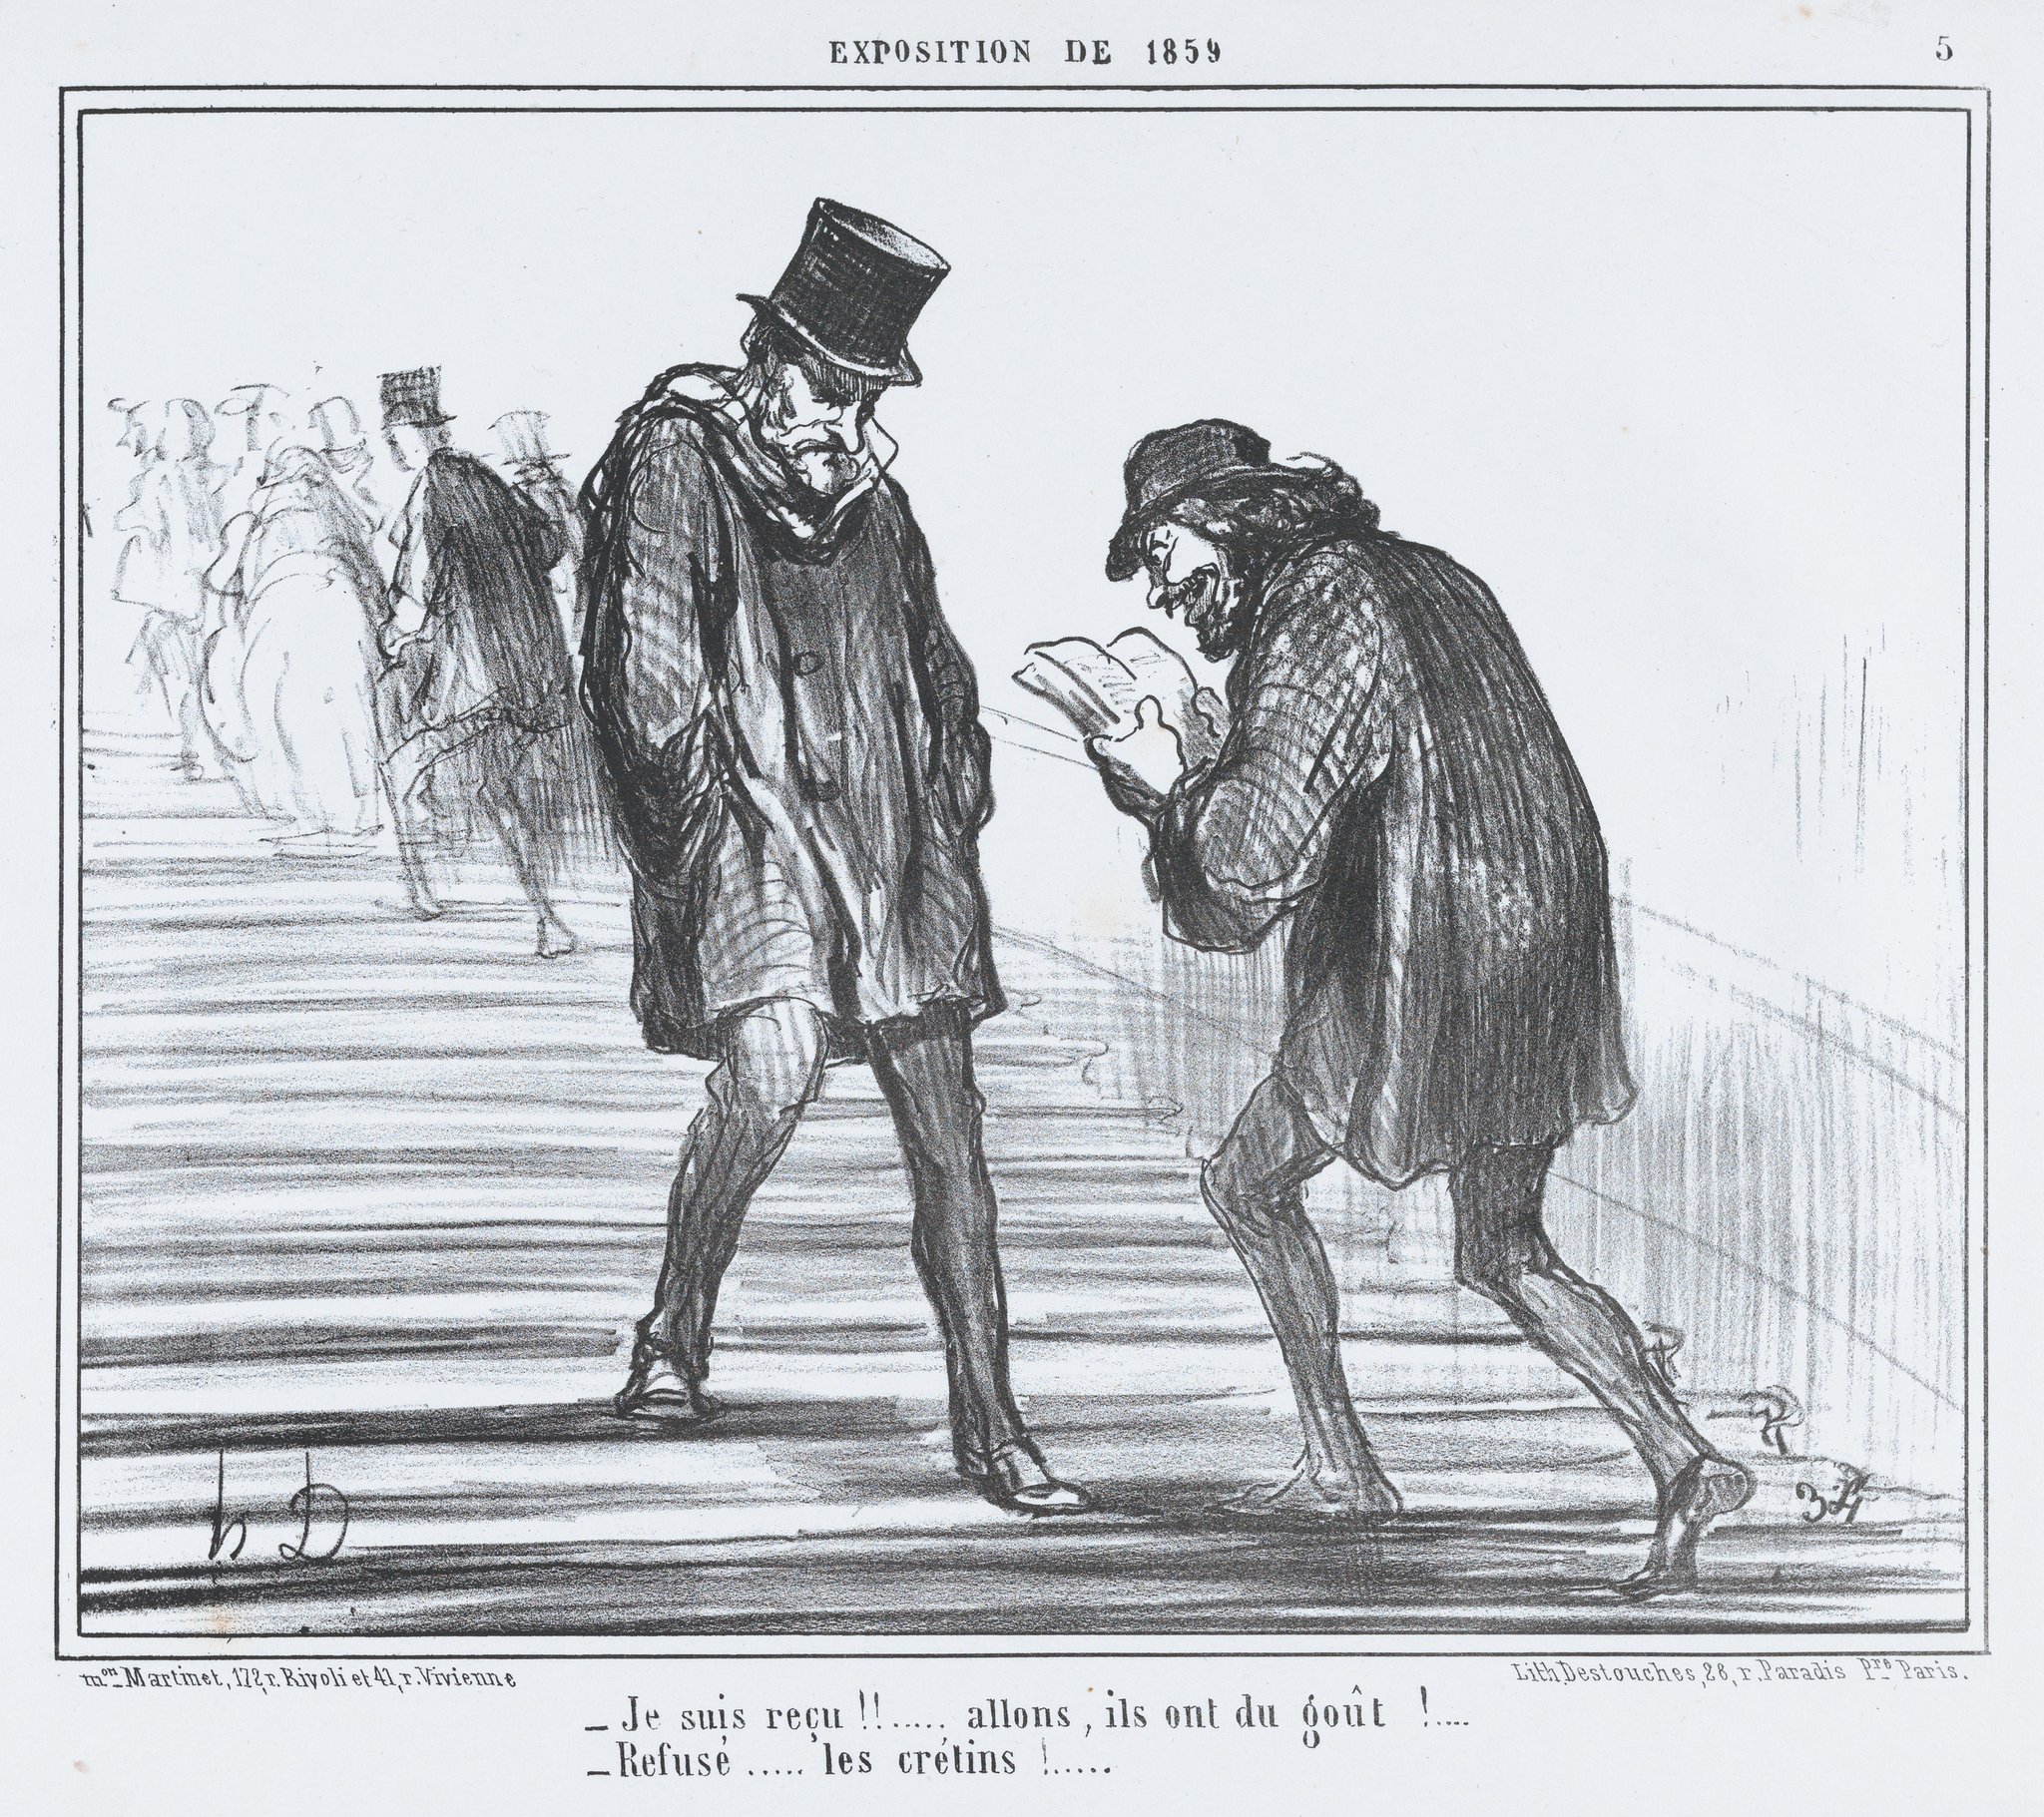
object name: print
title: Je suis reçu!!..., from L'Exposition de 1859, published in Le Charivari, April 22, 1859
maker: honoré daumier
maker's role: artist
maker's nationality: french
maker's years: 1808-1879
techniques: lithograph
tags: men,reading